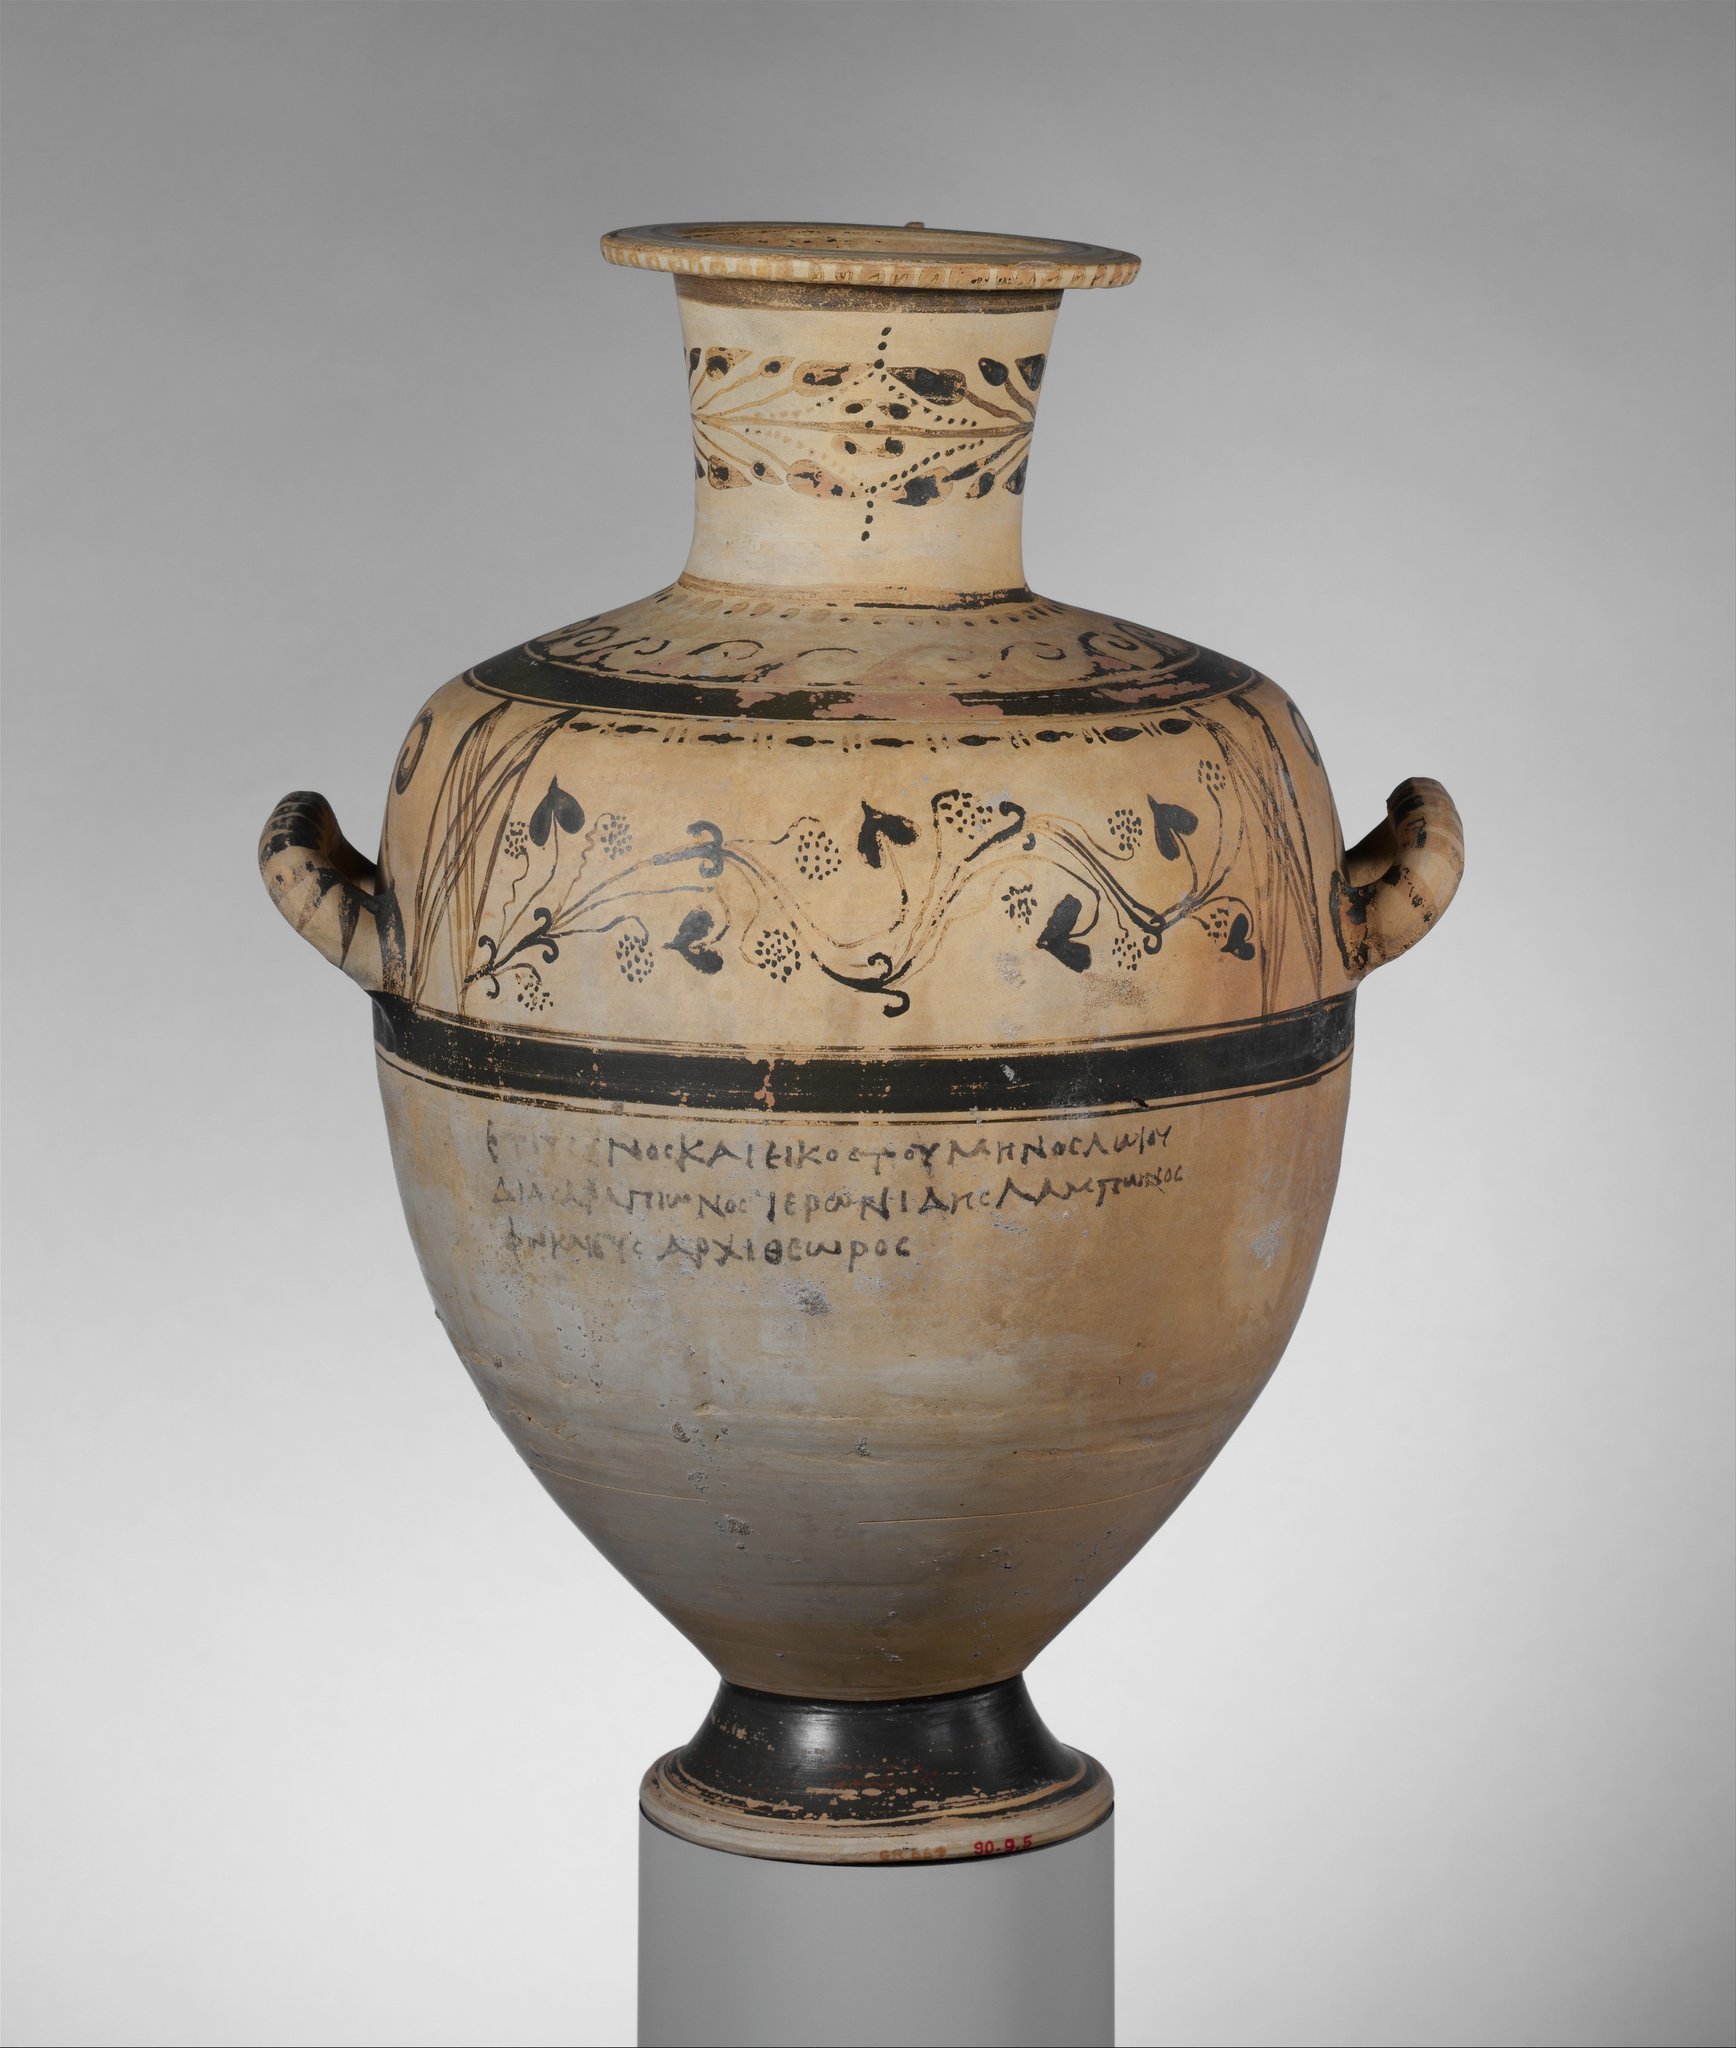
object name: hydria, hadra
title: Terracotta Hadra hydria (water jar)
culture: greek, cretan or ptolemaic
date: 226-225 BCE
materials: terracotta